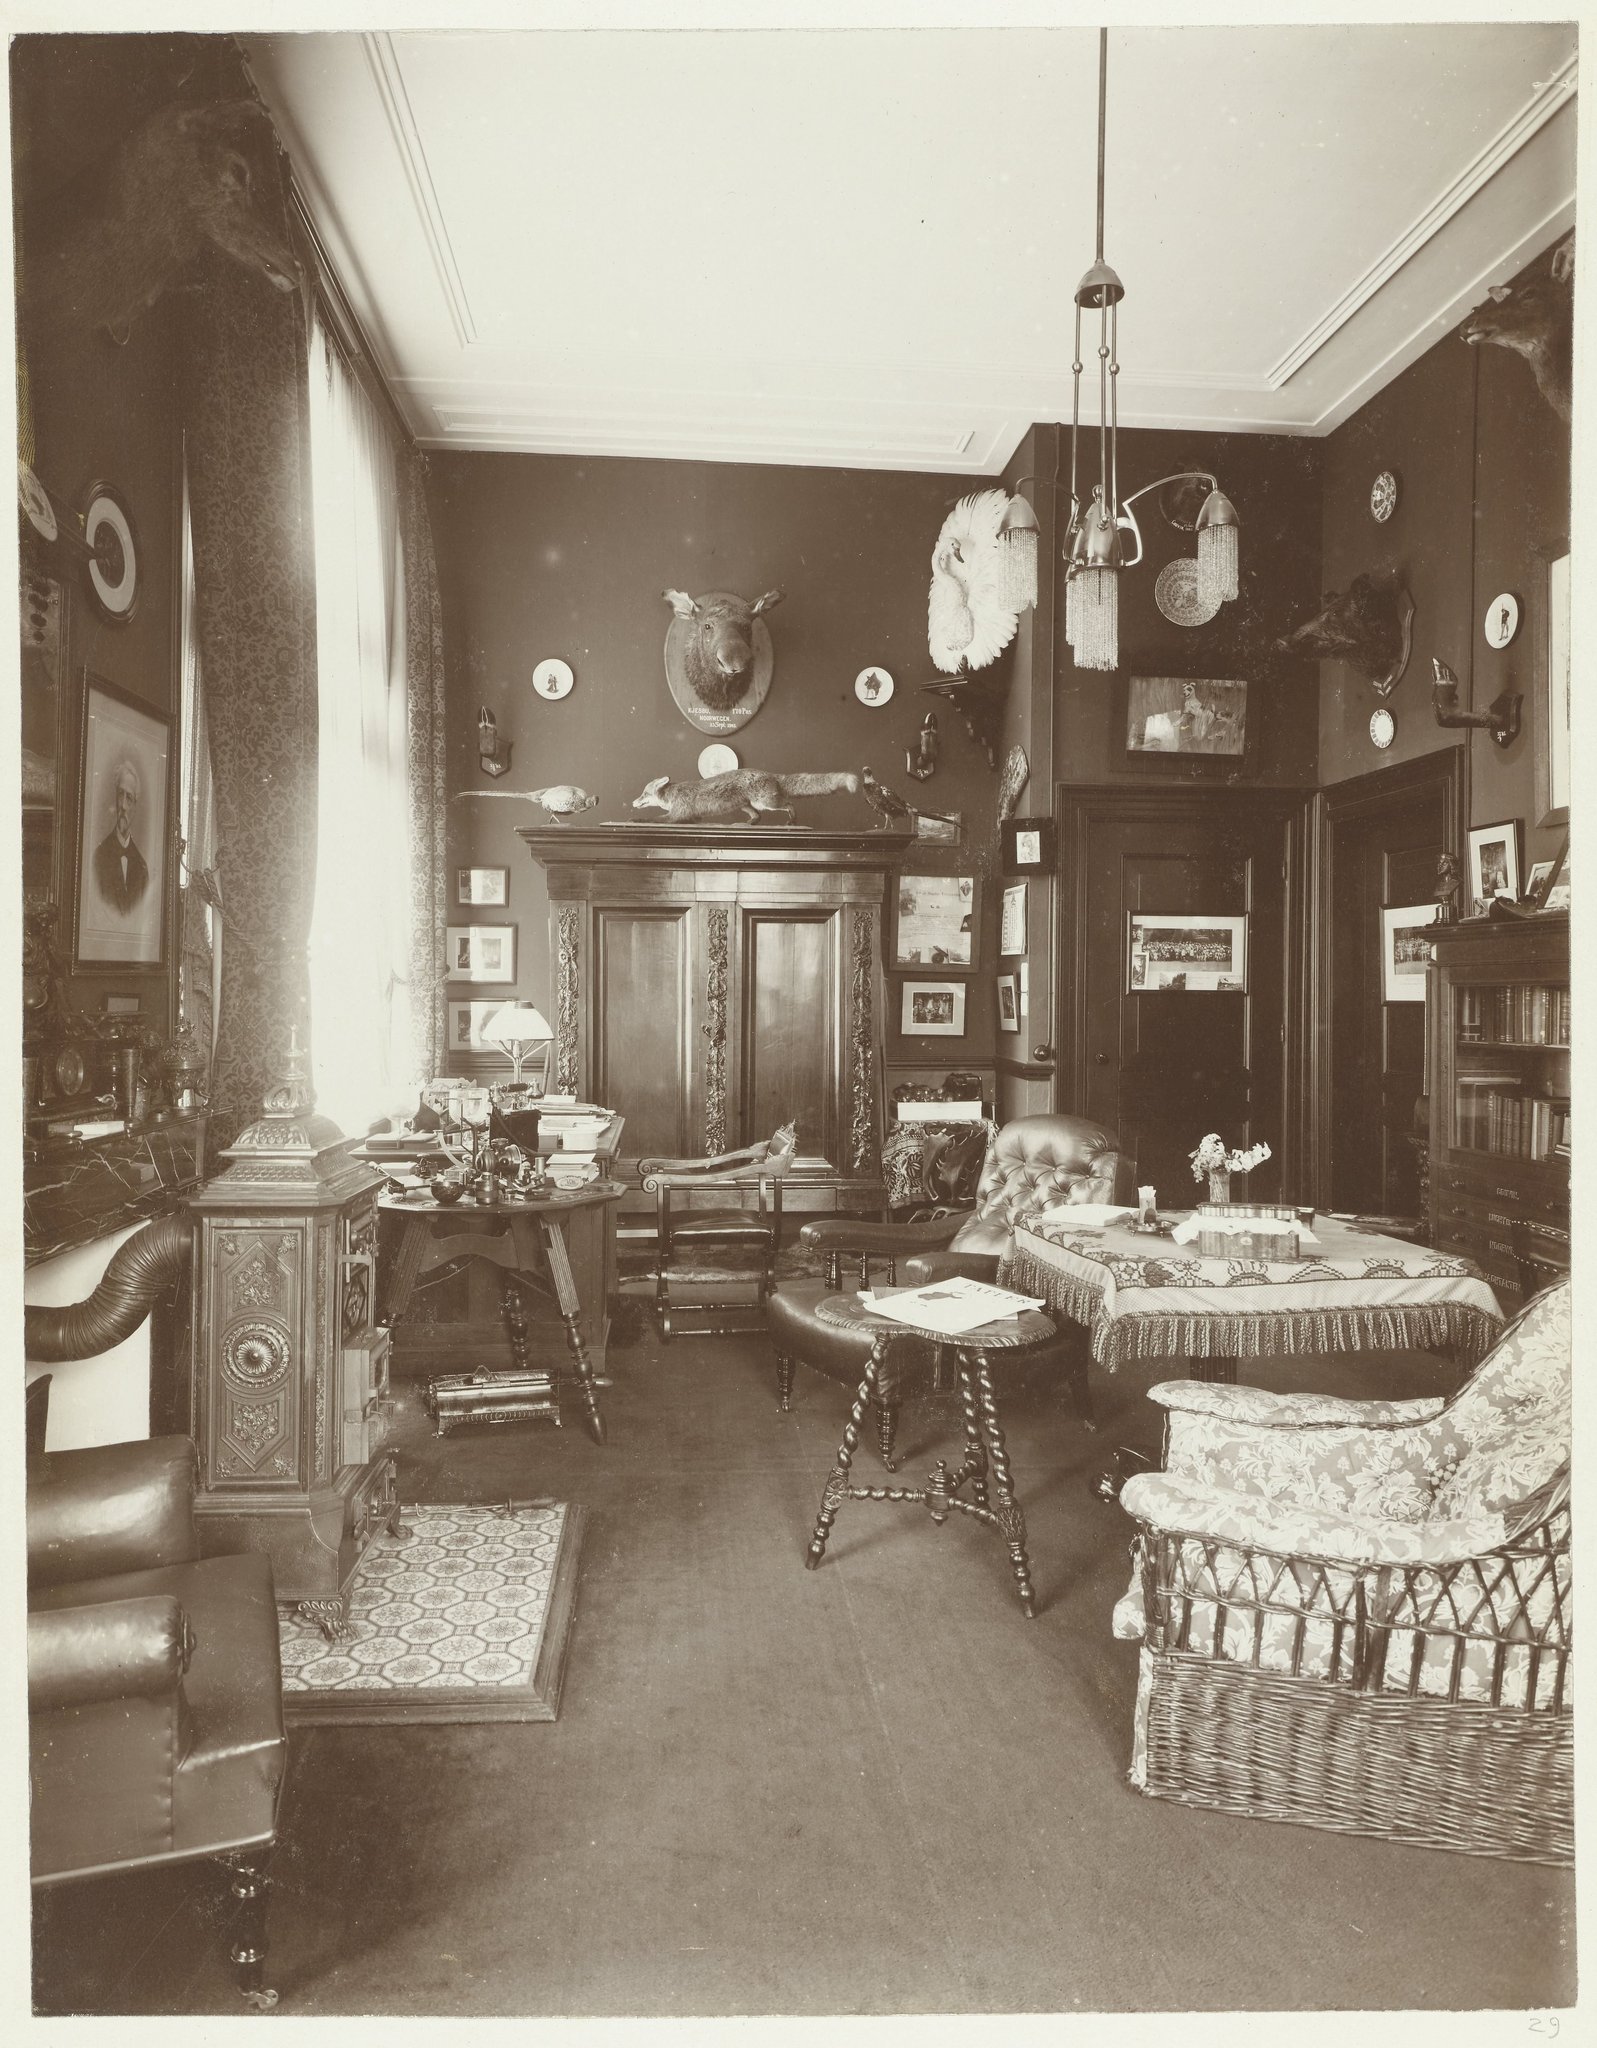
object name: photograph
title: Kamer in landhuis De Wildbaan, Driebergen, met bureau, studieboeken en jachttrofeeën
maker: henry pauw van wieldrecht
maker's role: fotograaf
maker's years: 1863-1912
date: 1903-1907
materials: paper, photographic support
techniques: gelatin silver print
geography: netherlands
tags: driebergen